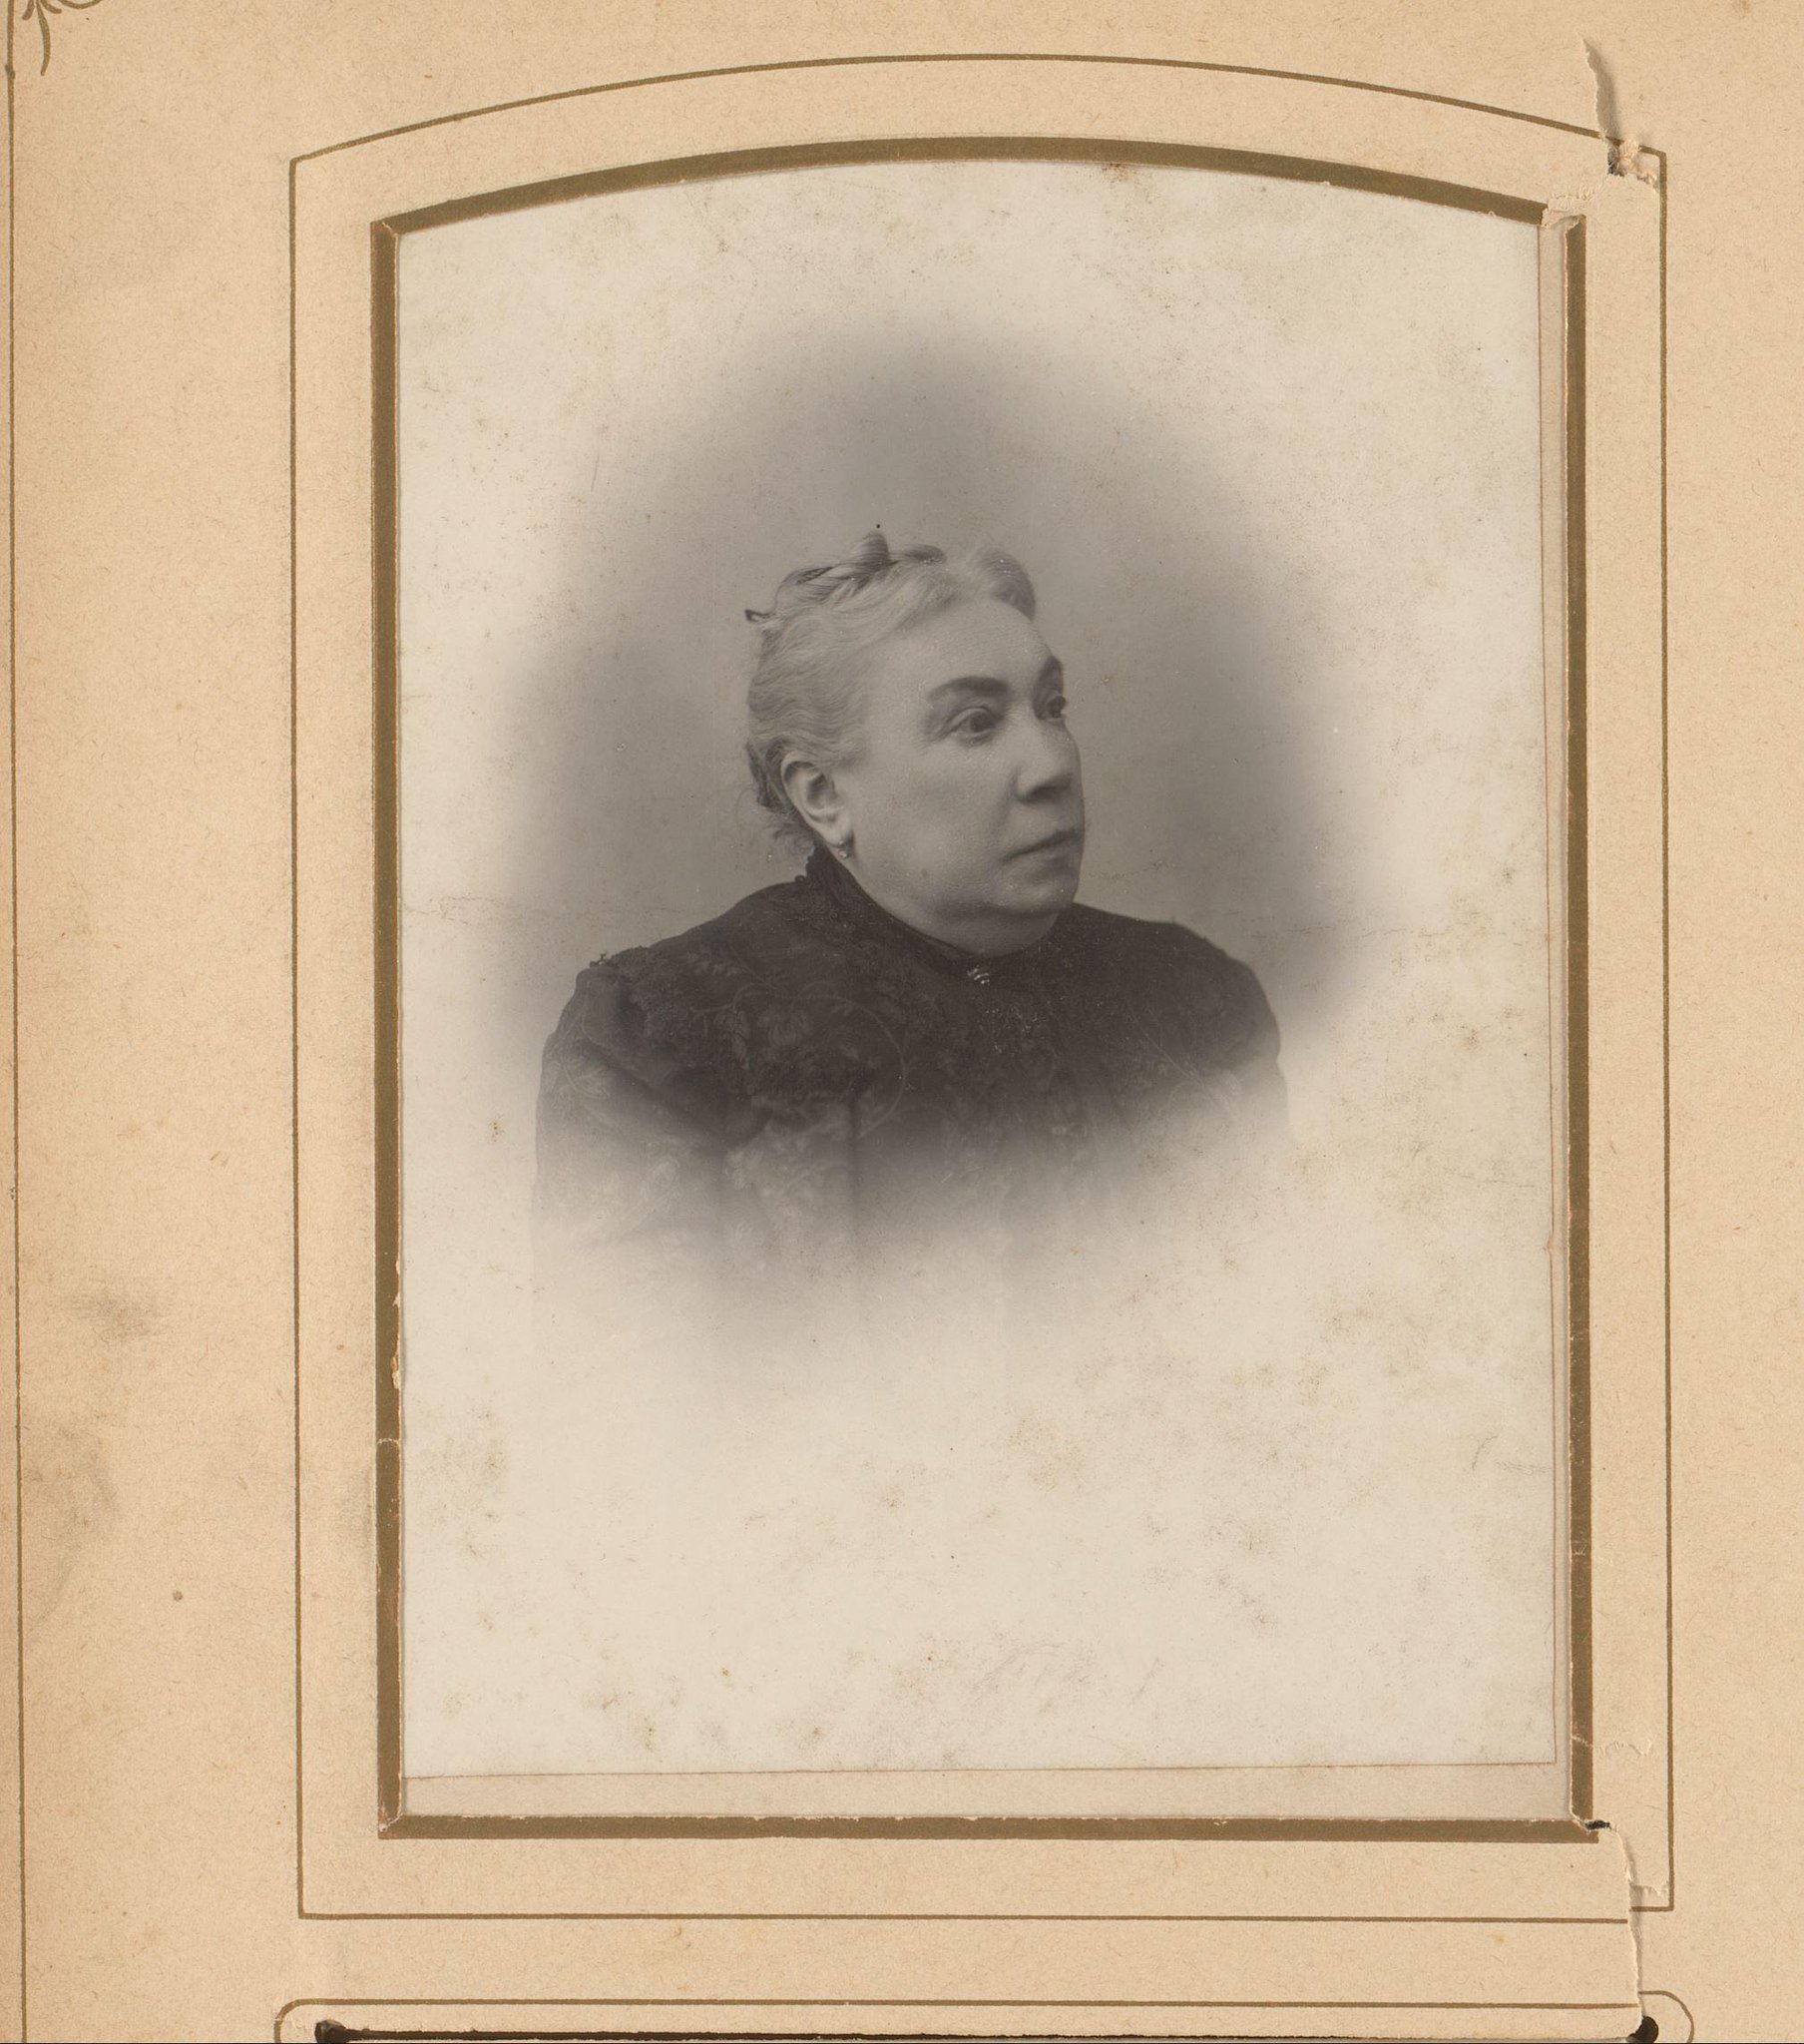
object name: album leaf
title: Portret van Wilhelmina Buys-Mossel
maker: paul ferdinand götte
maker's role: fotograaf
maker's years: 1867-1931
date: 1899-1904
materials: paper, cardboard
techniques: gelatin silver print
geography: amsterdam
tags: historical persons - bb - woman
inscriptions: address: ‘Amsterdam/ Keizersgracht 533.’